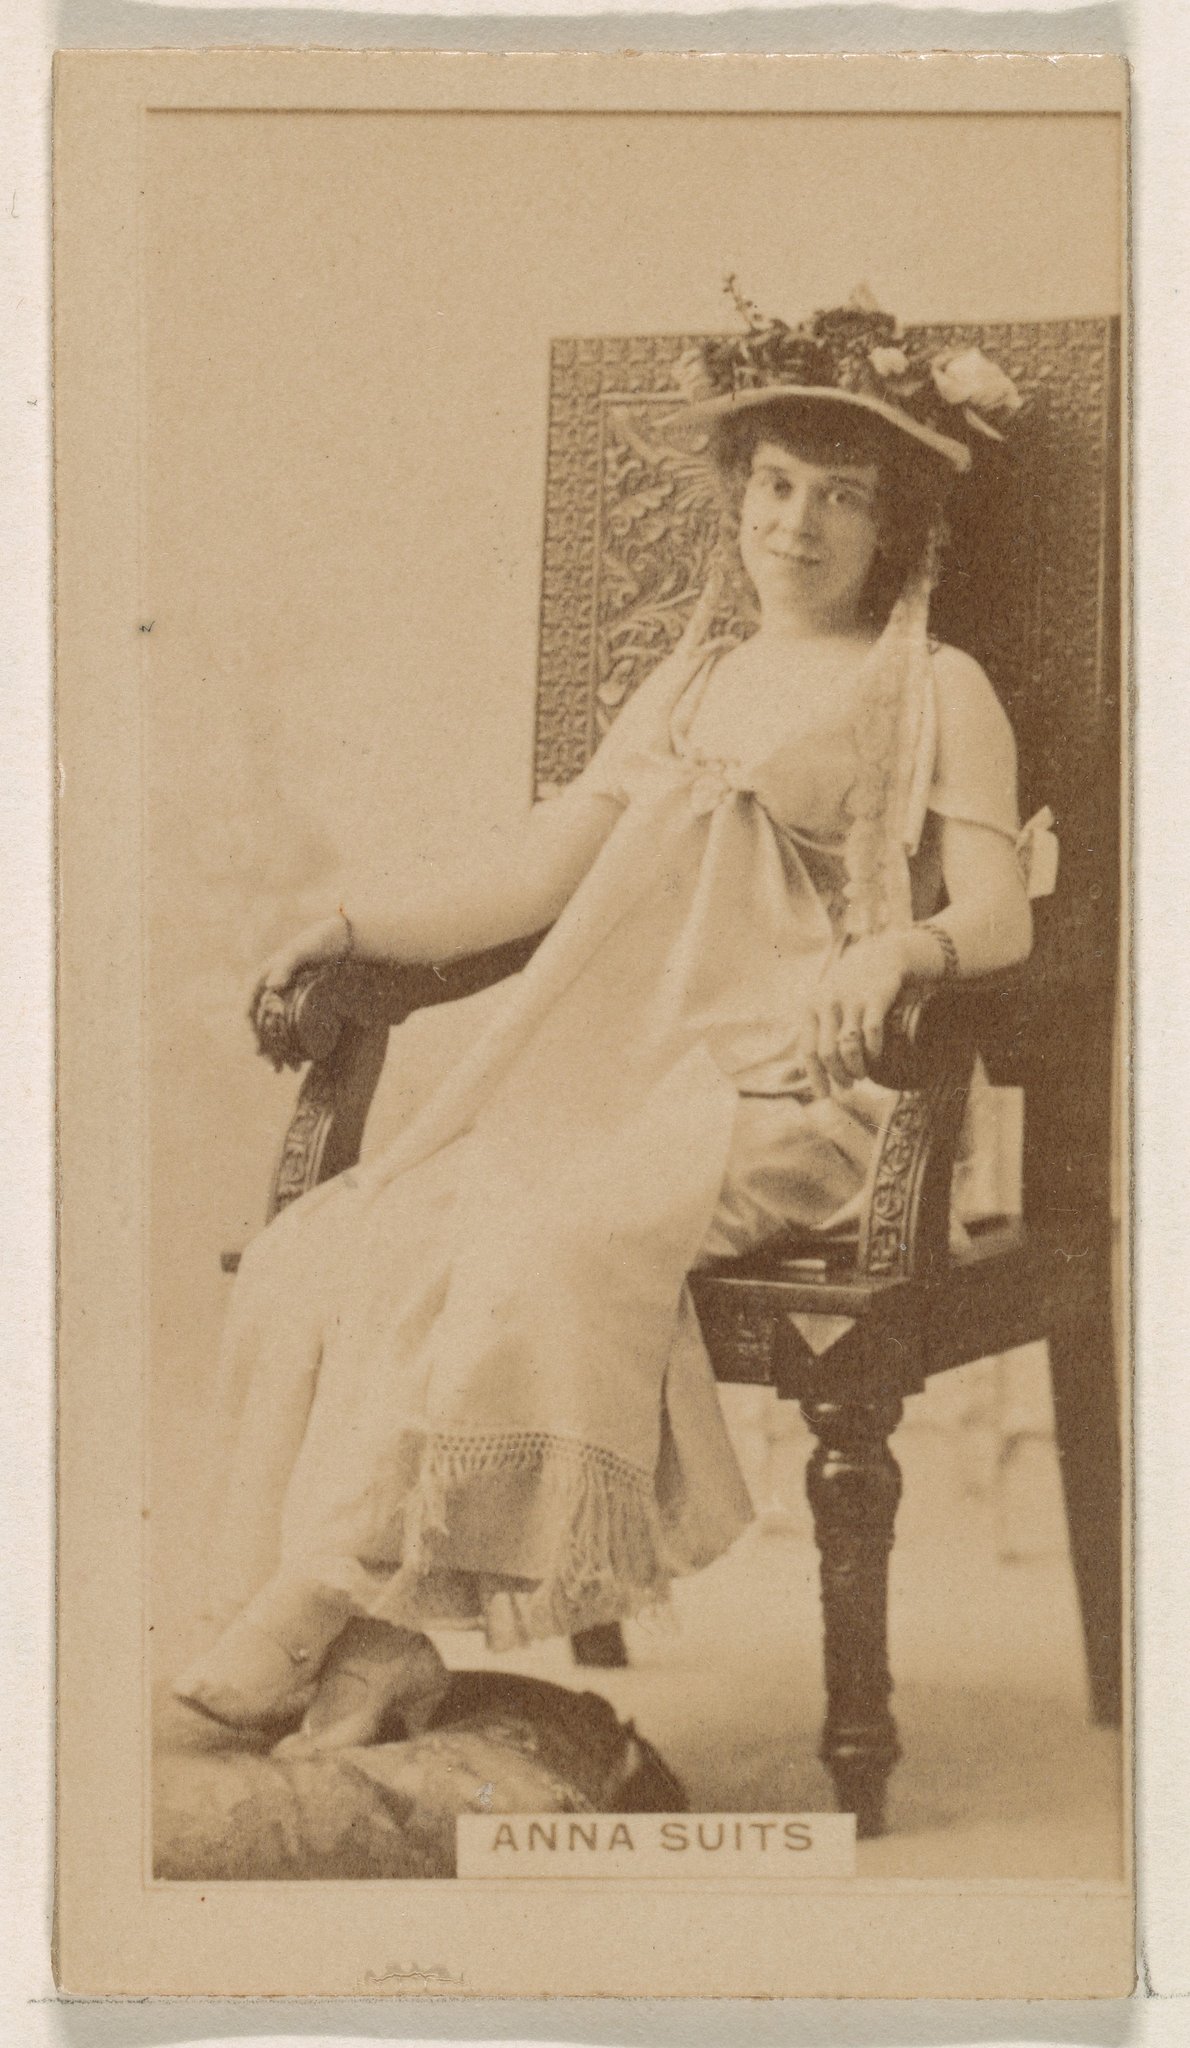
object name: photograph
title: Anna Suits, from the Actresses series (N245) issued by Kinney Brothers to promote Sweet Caporal Cigarettes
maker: kinney brothers tobacco company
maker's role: publisher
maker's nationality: american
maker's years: 1869-2011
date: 1890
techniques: albumen silver print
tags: portraits,women,actresses